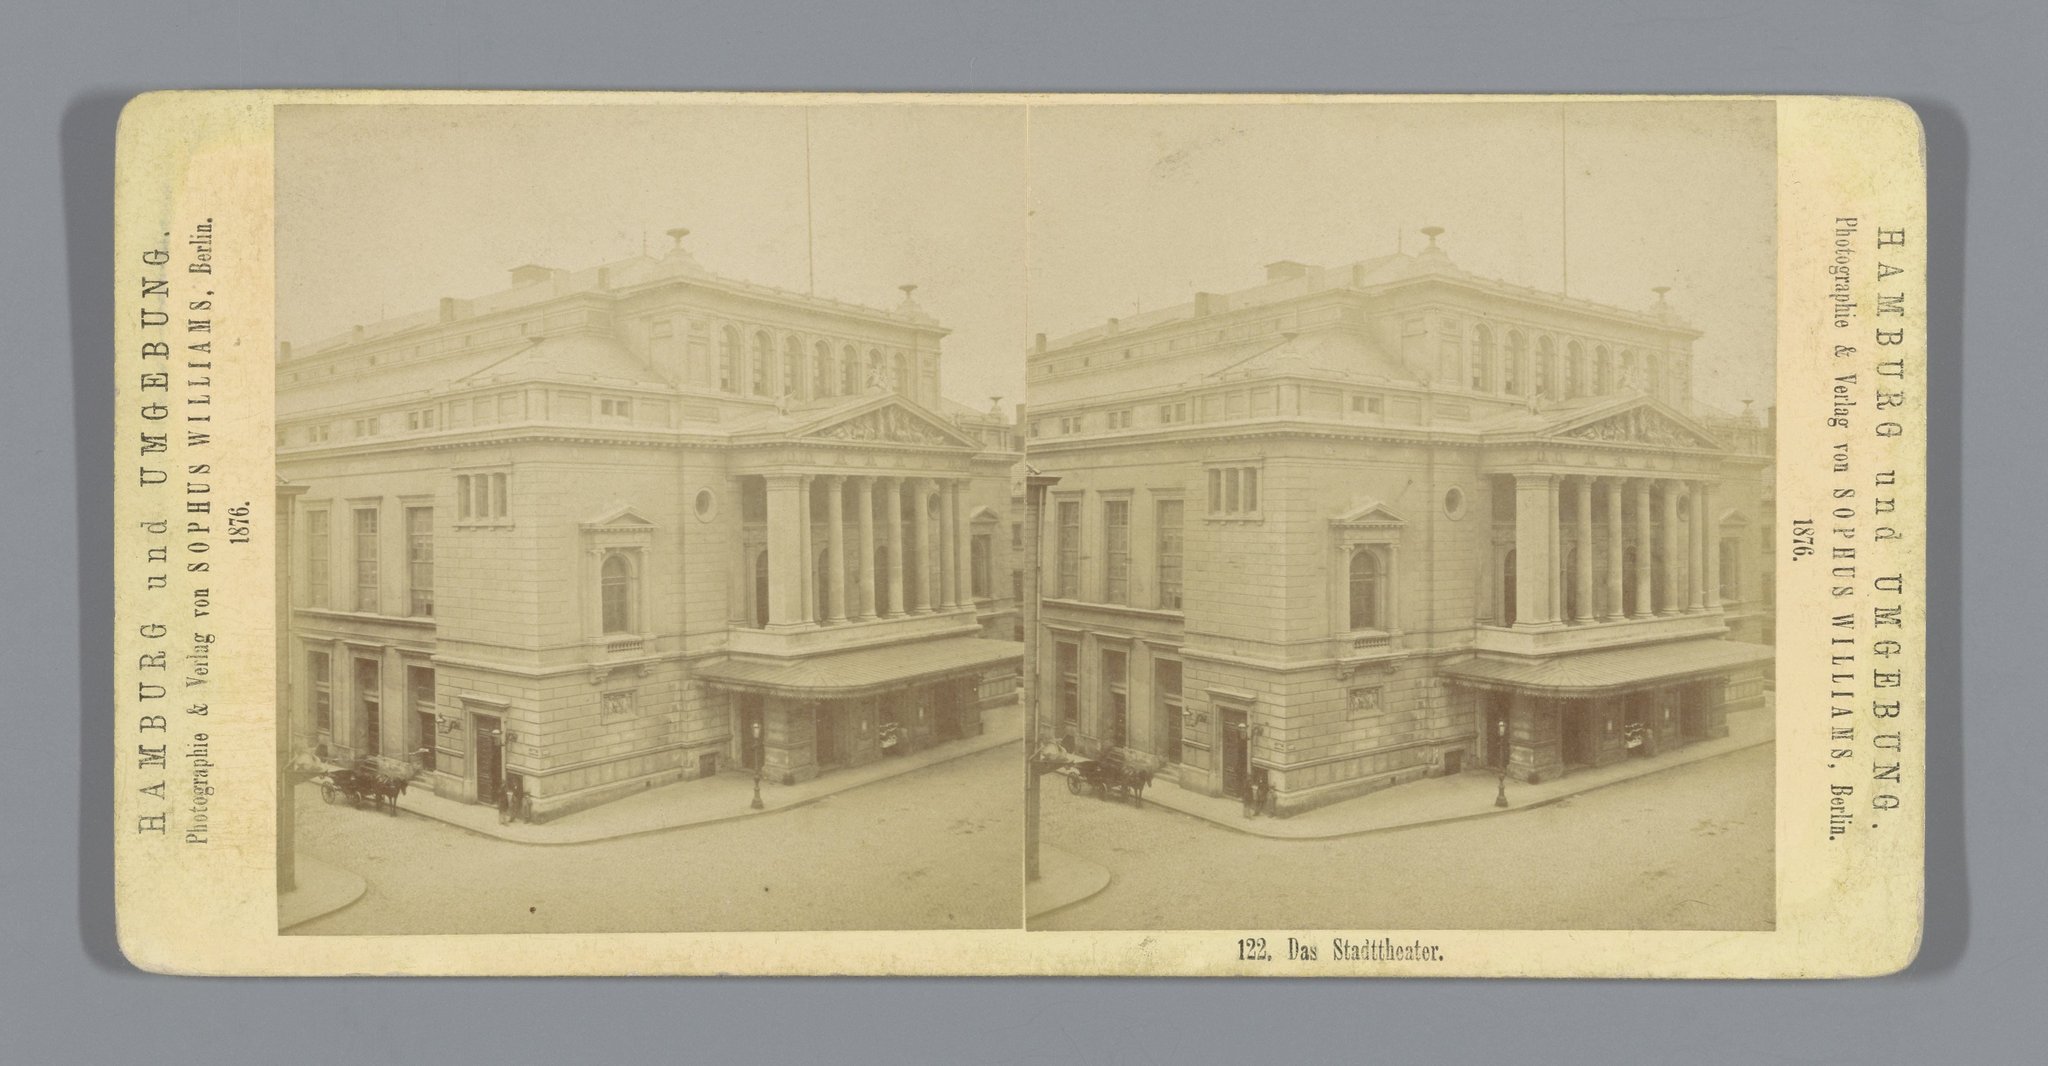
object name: stereograph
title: Hamburg und Umgebung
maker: sophus williams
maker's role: publisher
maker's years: 1835-1900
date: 1876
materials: cardboard, photographic support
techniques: albumen print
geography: hamburg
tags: façade (of house or building), opera house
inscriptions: number: ‘122.’